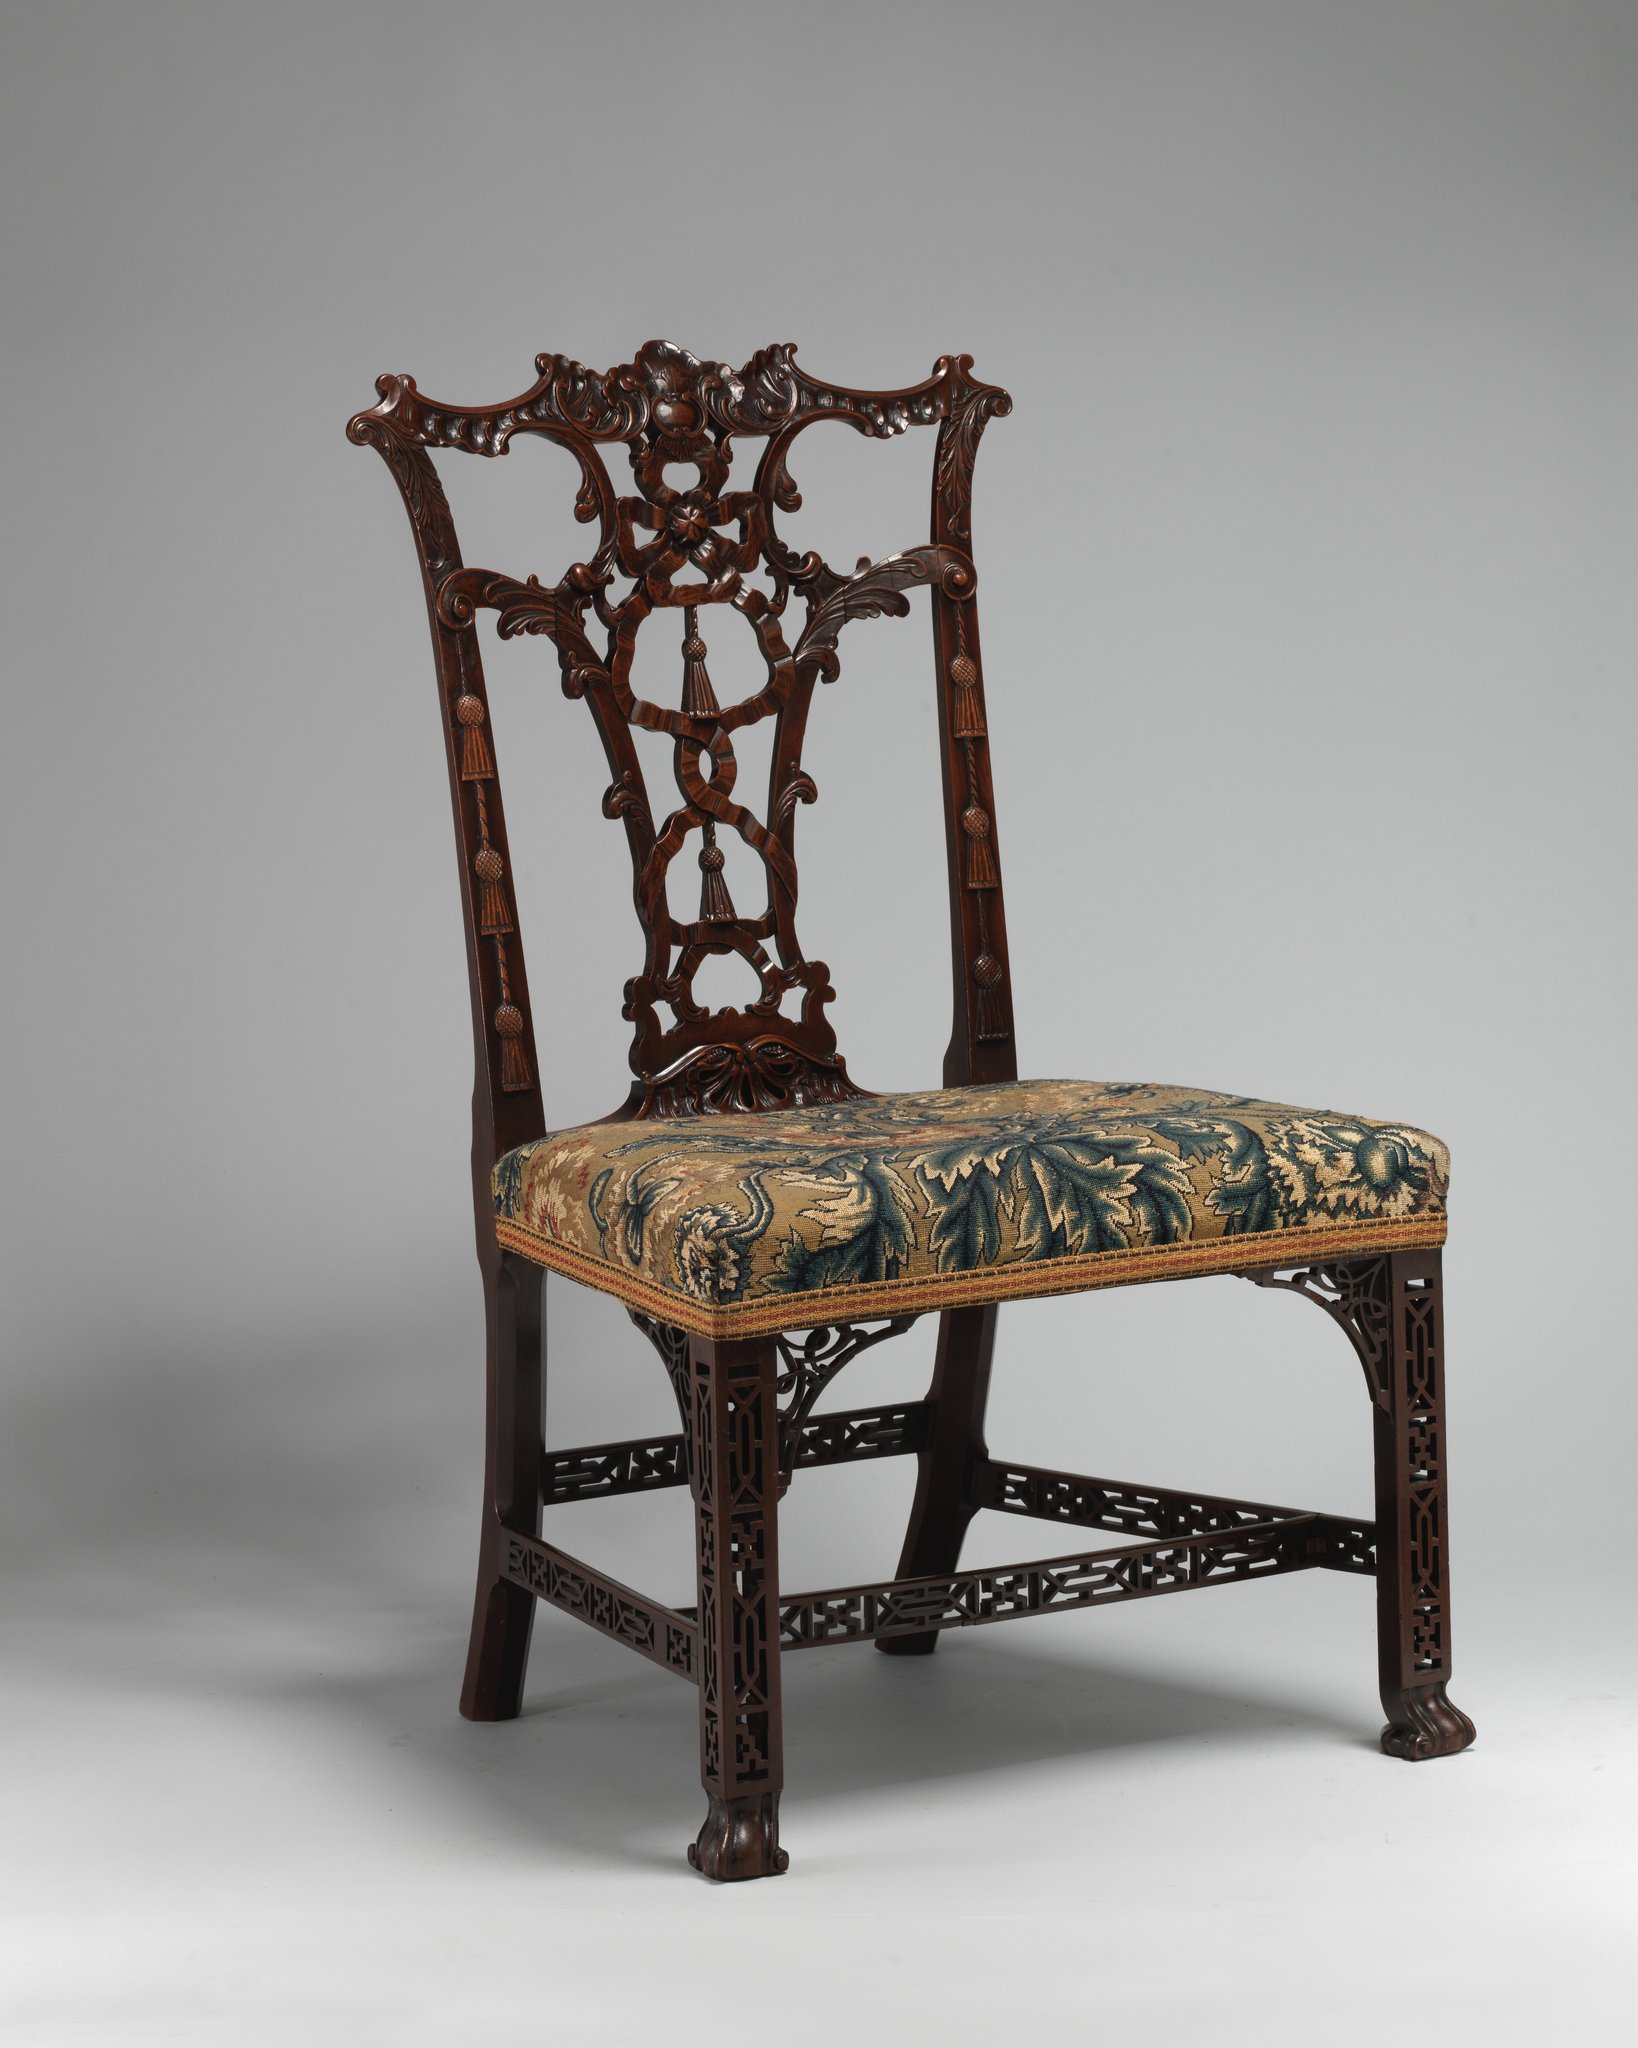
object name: side chair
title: Side chair (one of a pair)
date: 1755-1760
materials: canvas, wood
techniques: embroidery, stitching